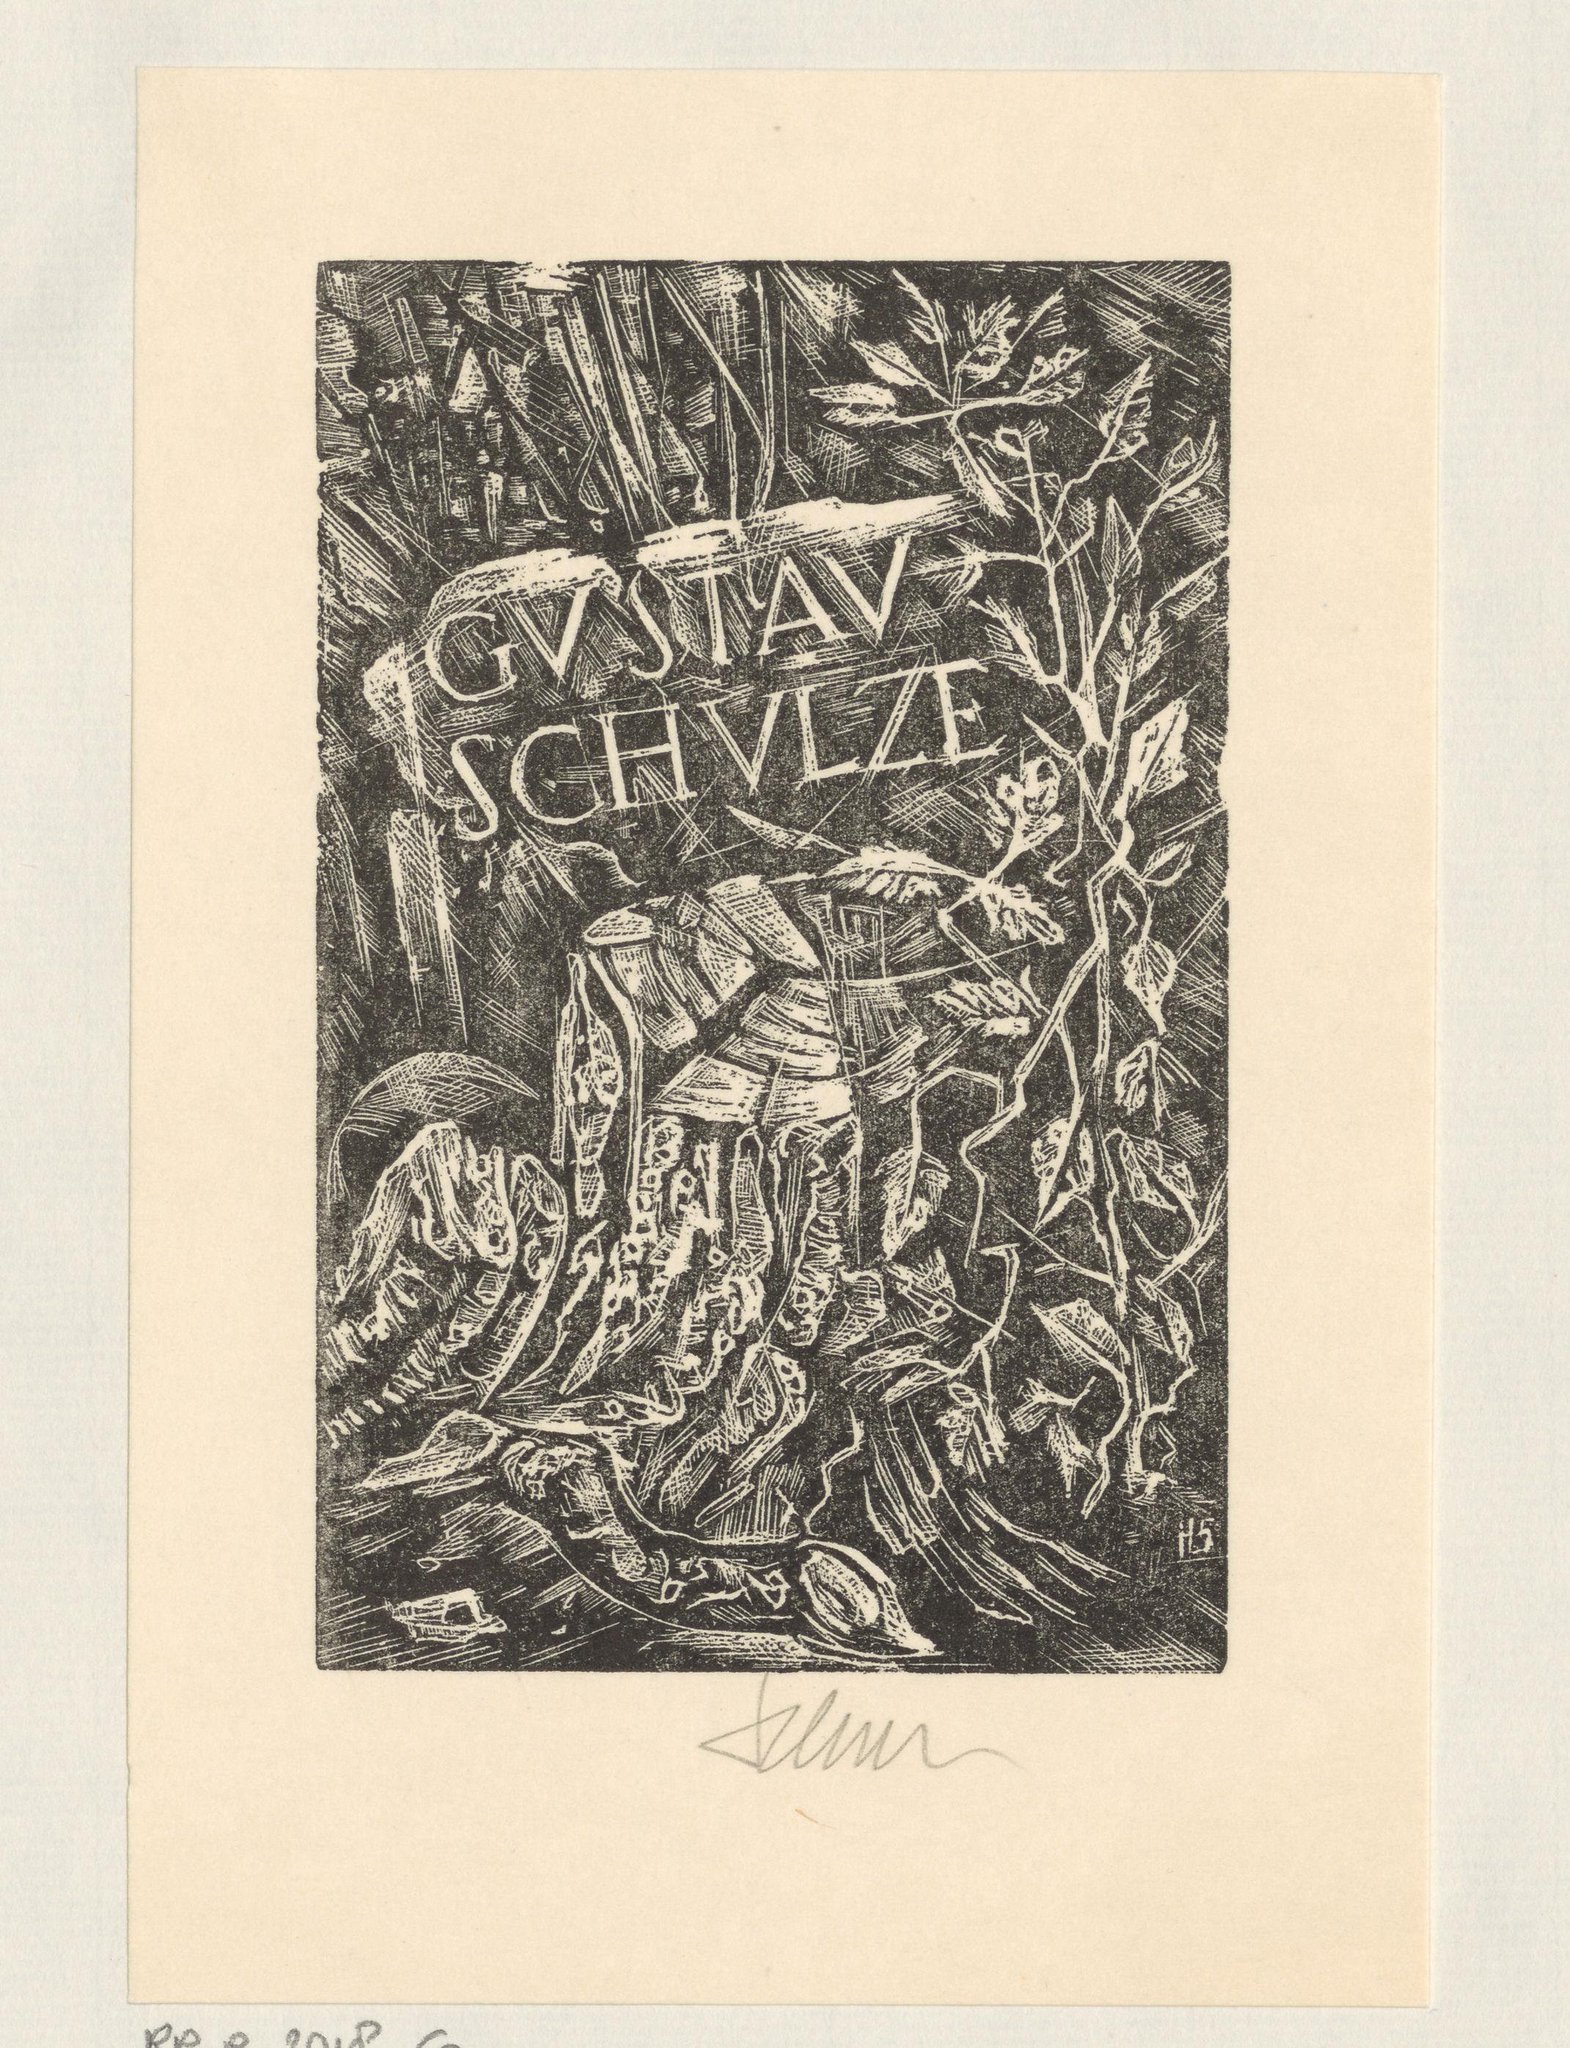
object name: bookplate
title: Ex libris van Gustav Schulze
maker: hans rudolf schulze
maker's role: print maker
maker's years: 1870-1951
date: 1880-1951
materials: paper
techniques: engraving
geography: germany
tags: trees, plants and herbs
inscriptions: signature: ‘Schulz’